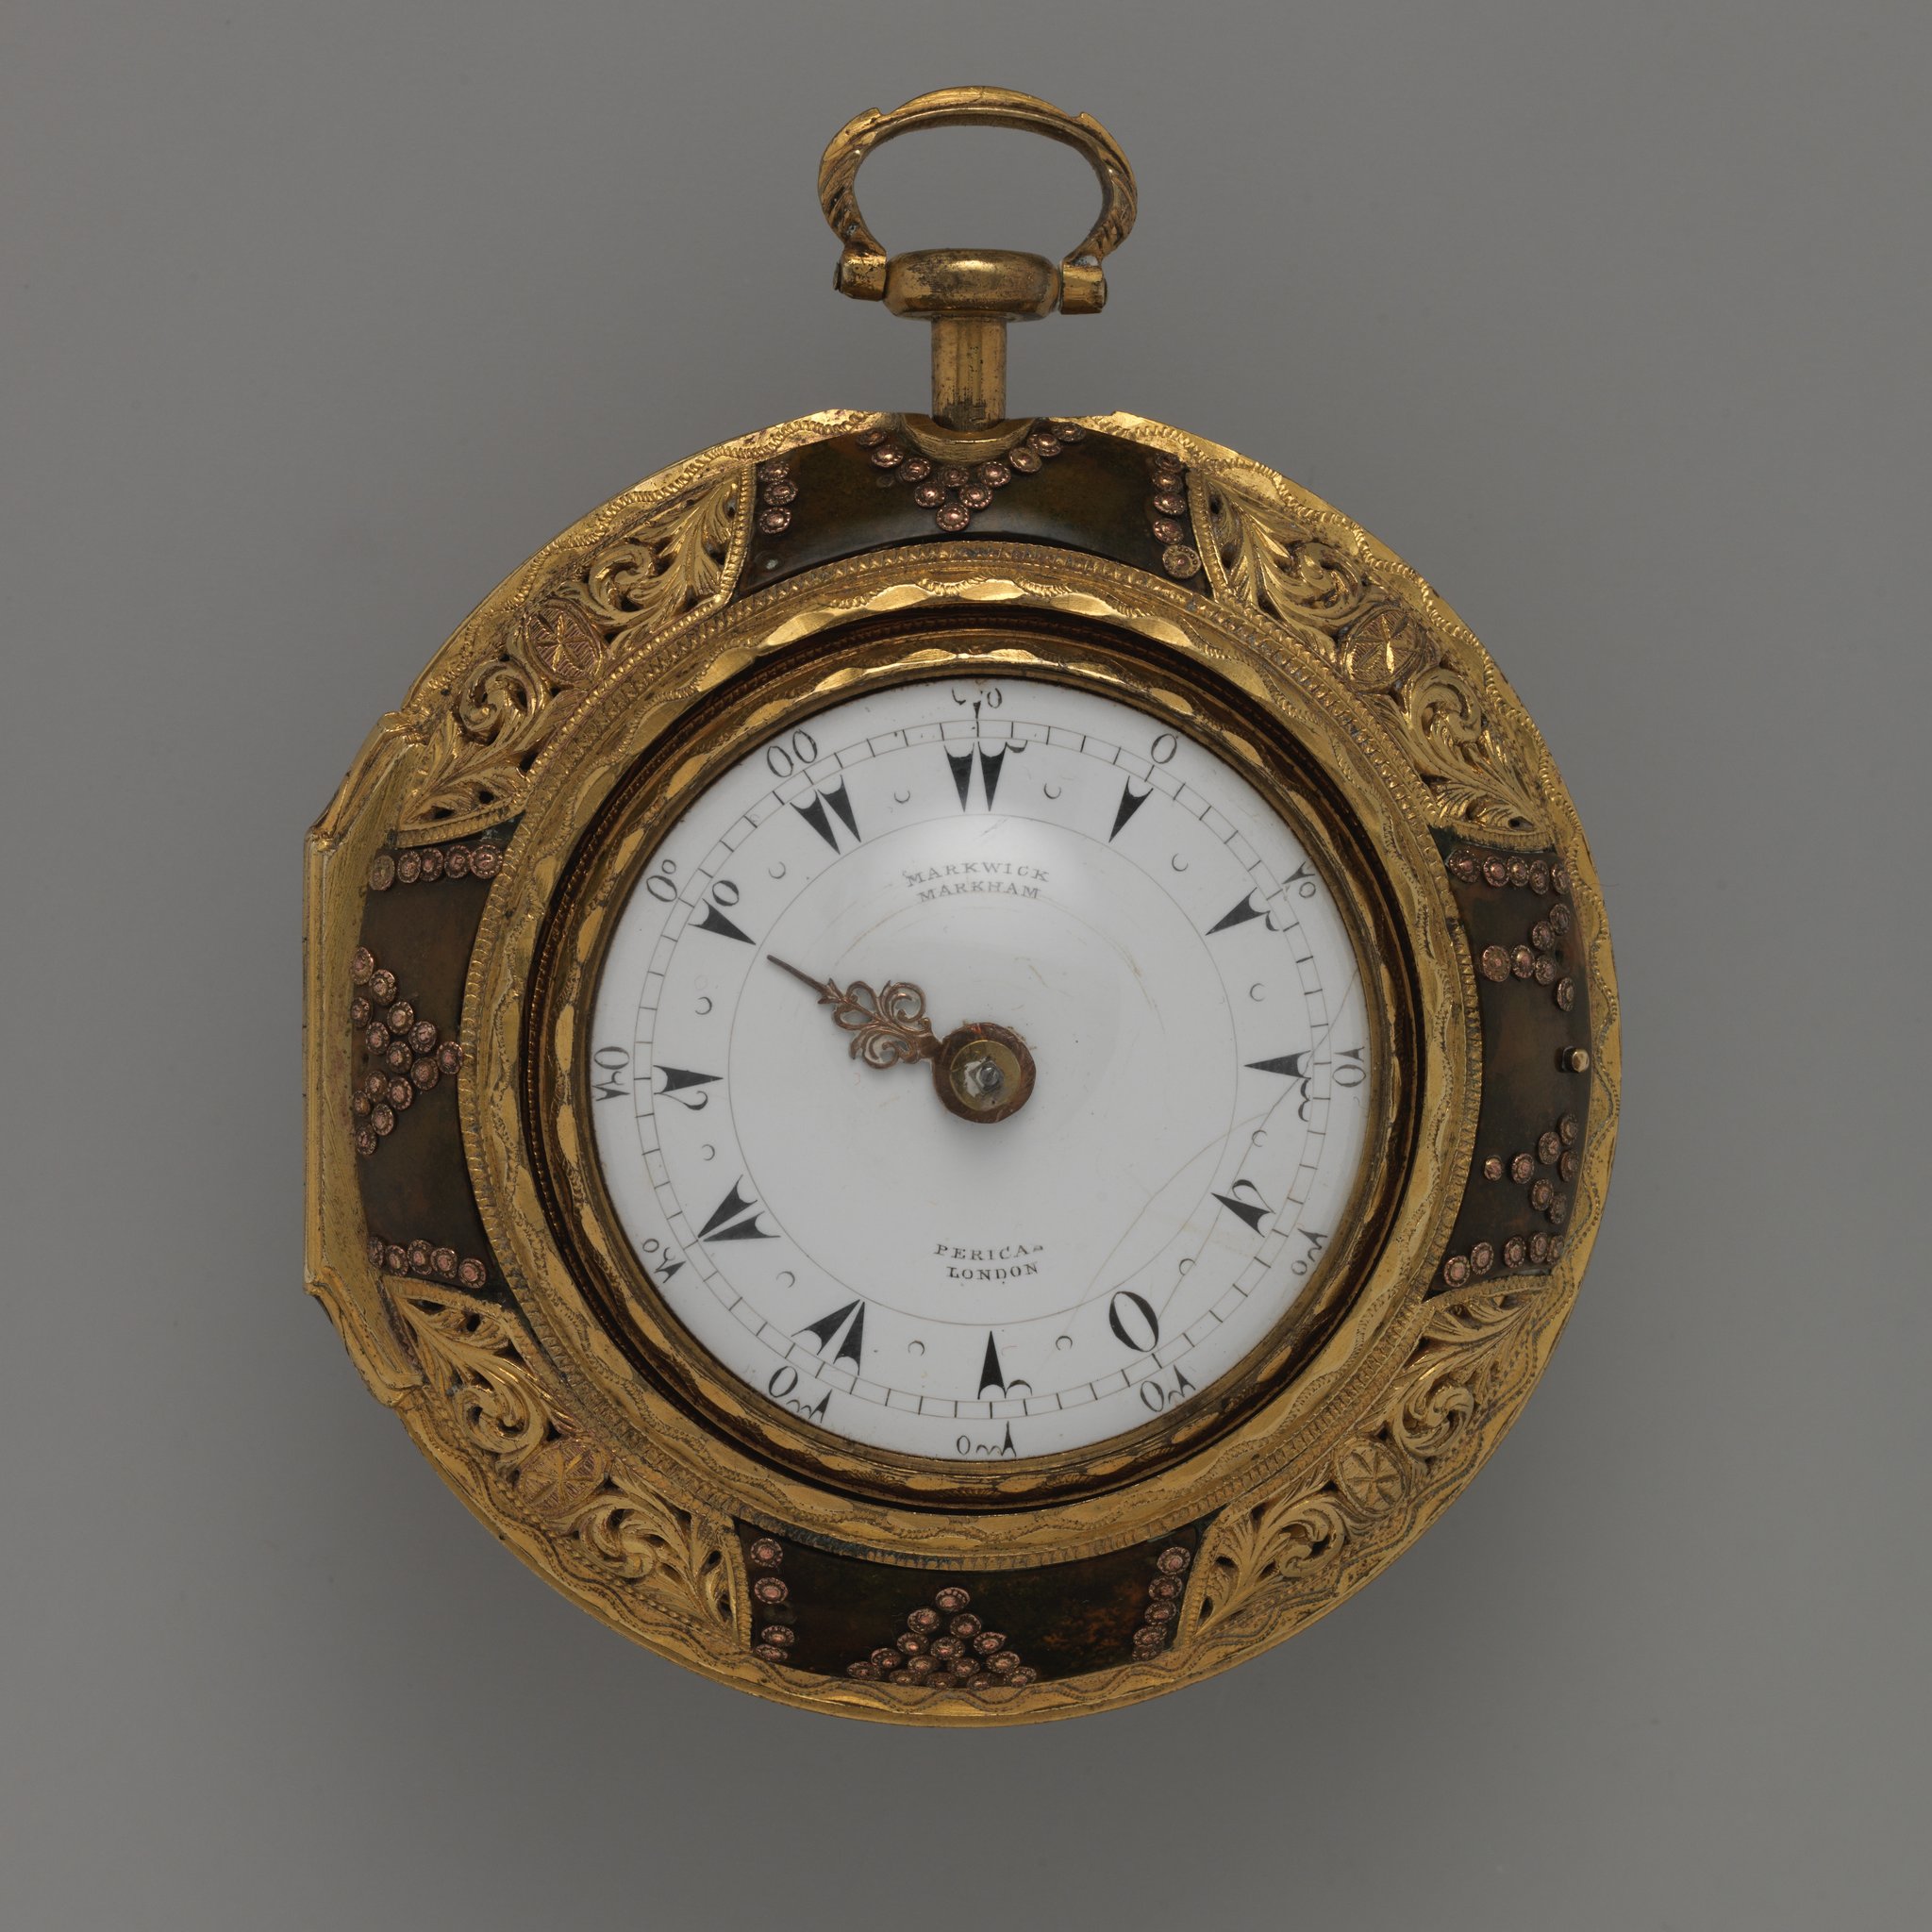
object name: clock watch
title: Clock-watch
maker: firm of markham, marwick, perigal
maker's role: maker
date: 1740-1780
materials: enamel, gilt, horn, metal